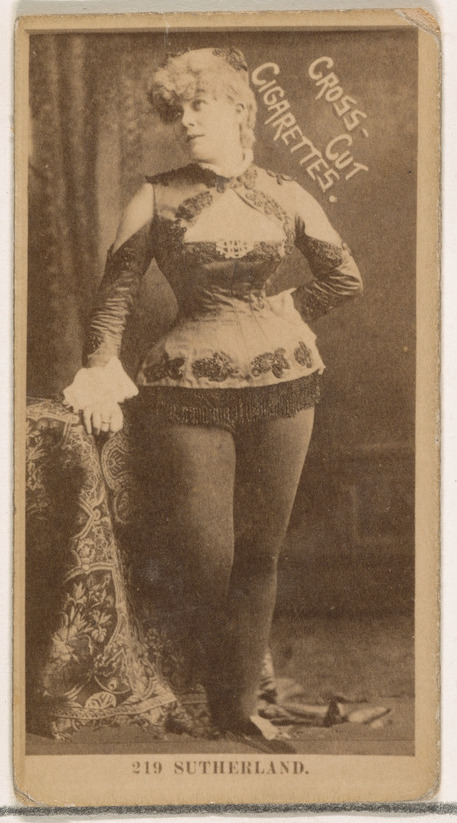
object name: print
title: Card Number 219, Sutherland, from the Actors and Actresses series (N145-2) issued by Duke Sons & Co. to promote Cross Cut Cigarettes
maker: w. duke, sons & co.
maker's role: publisher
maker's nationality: american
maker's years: 1870-1920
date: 1880-1889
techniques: albumen silver print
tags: portraits,women,actresses